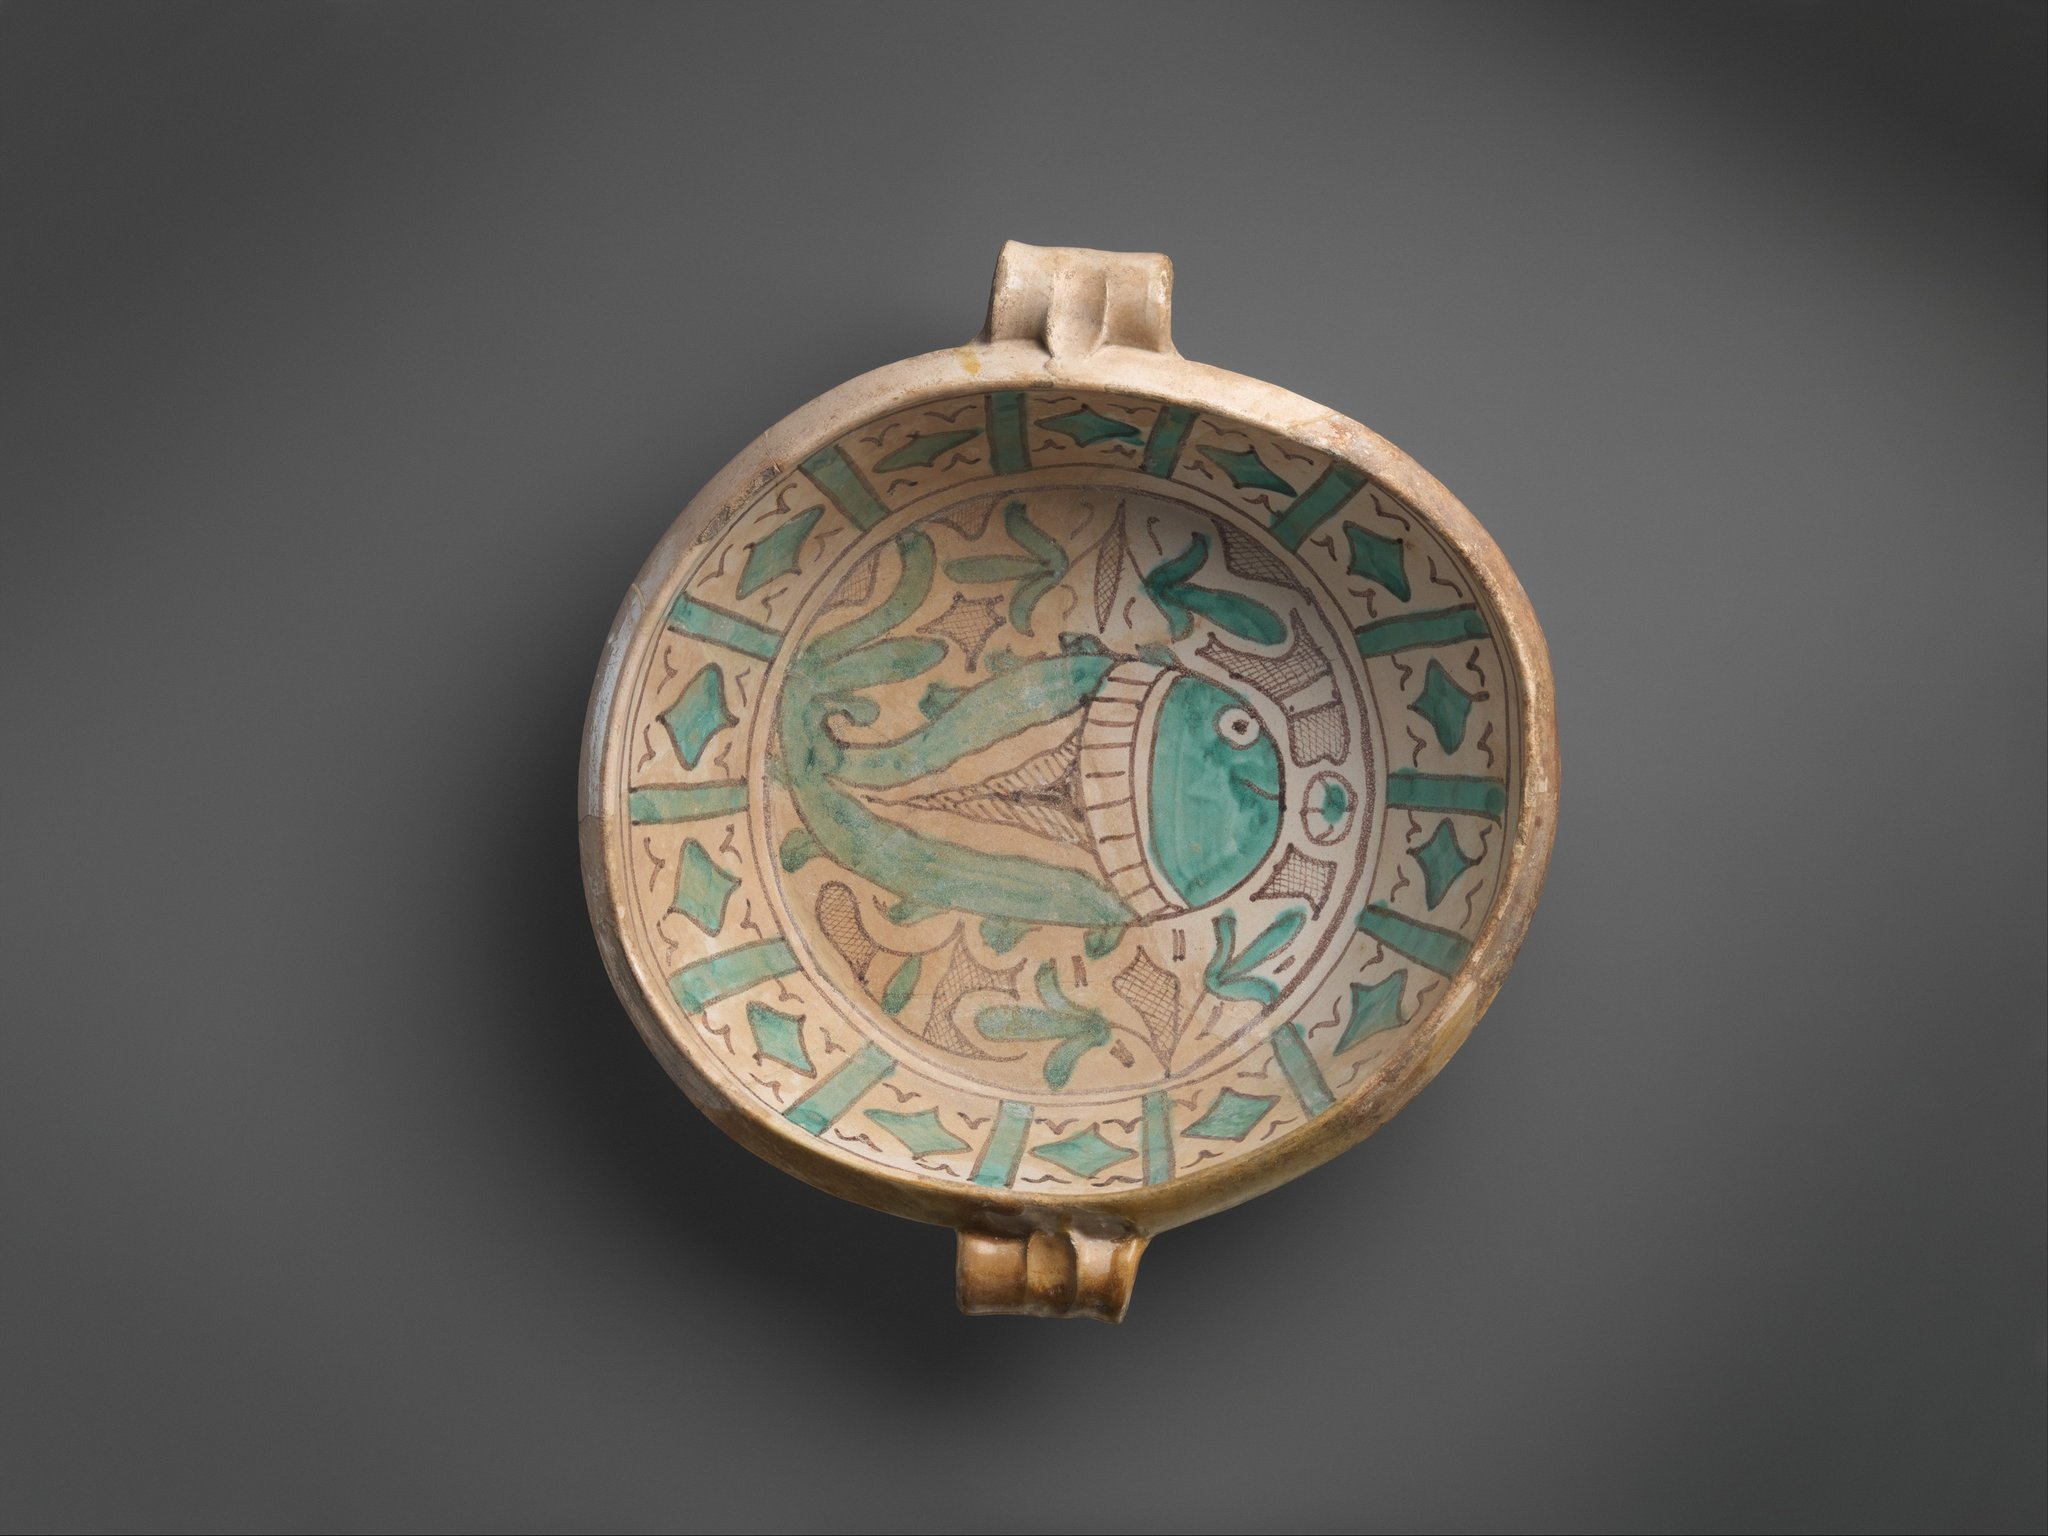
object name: bowl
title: Two-Handled Bowl with Fish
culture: italian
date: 1400-1430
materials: earthenware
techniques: glazing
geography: italy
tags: fish